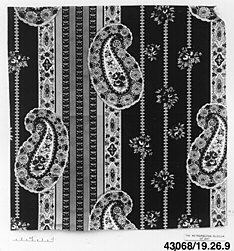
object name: sample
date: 1840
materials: cotton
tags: flowers